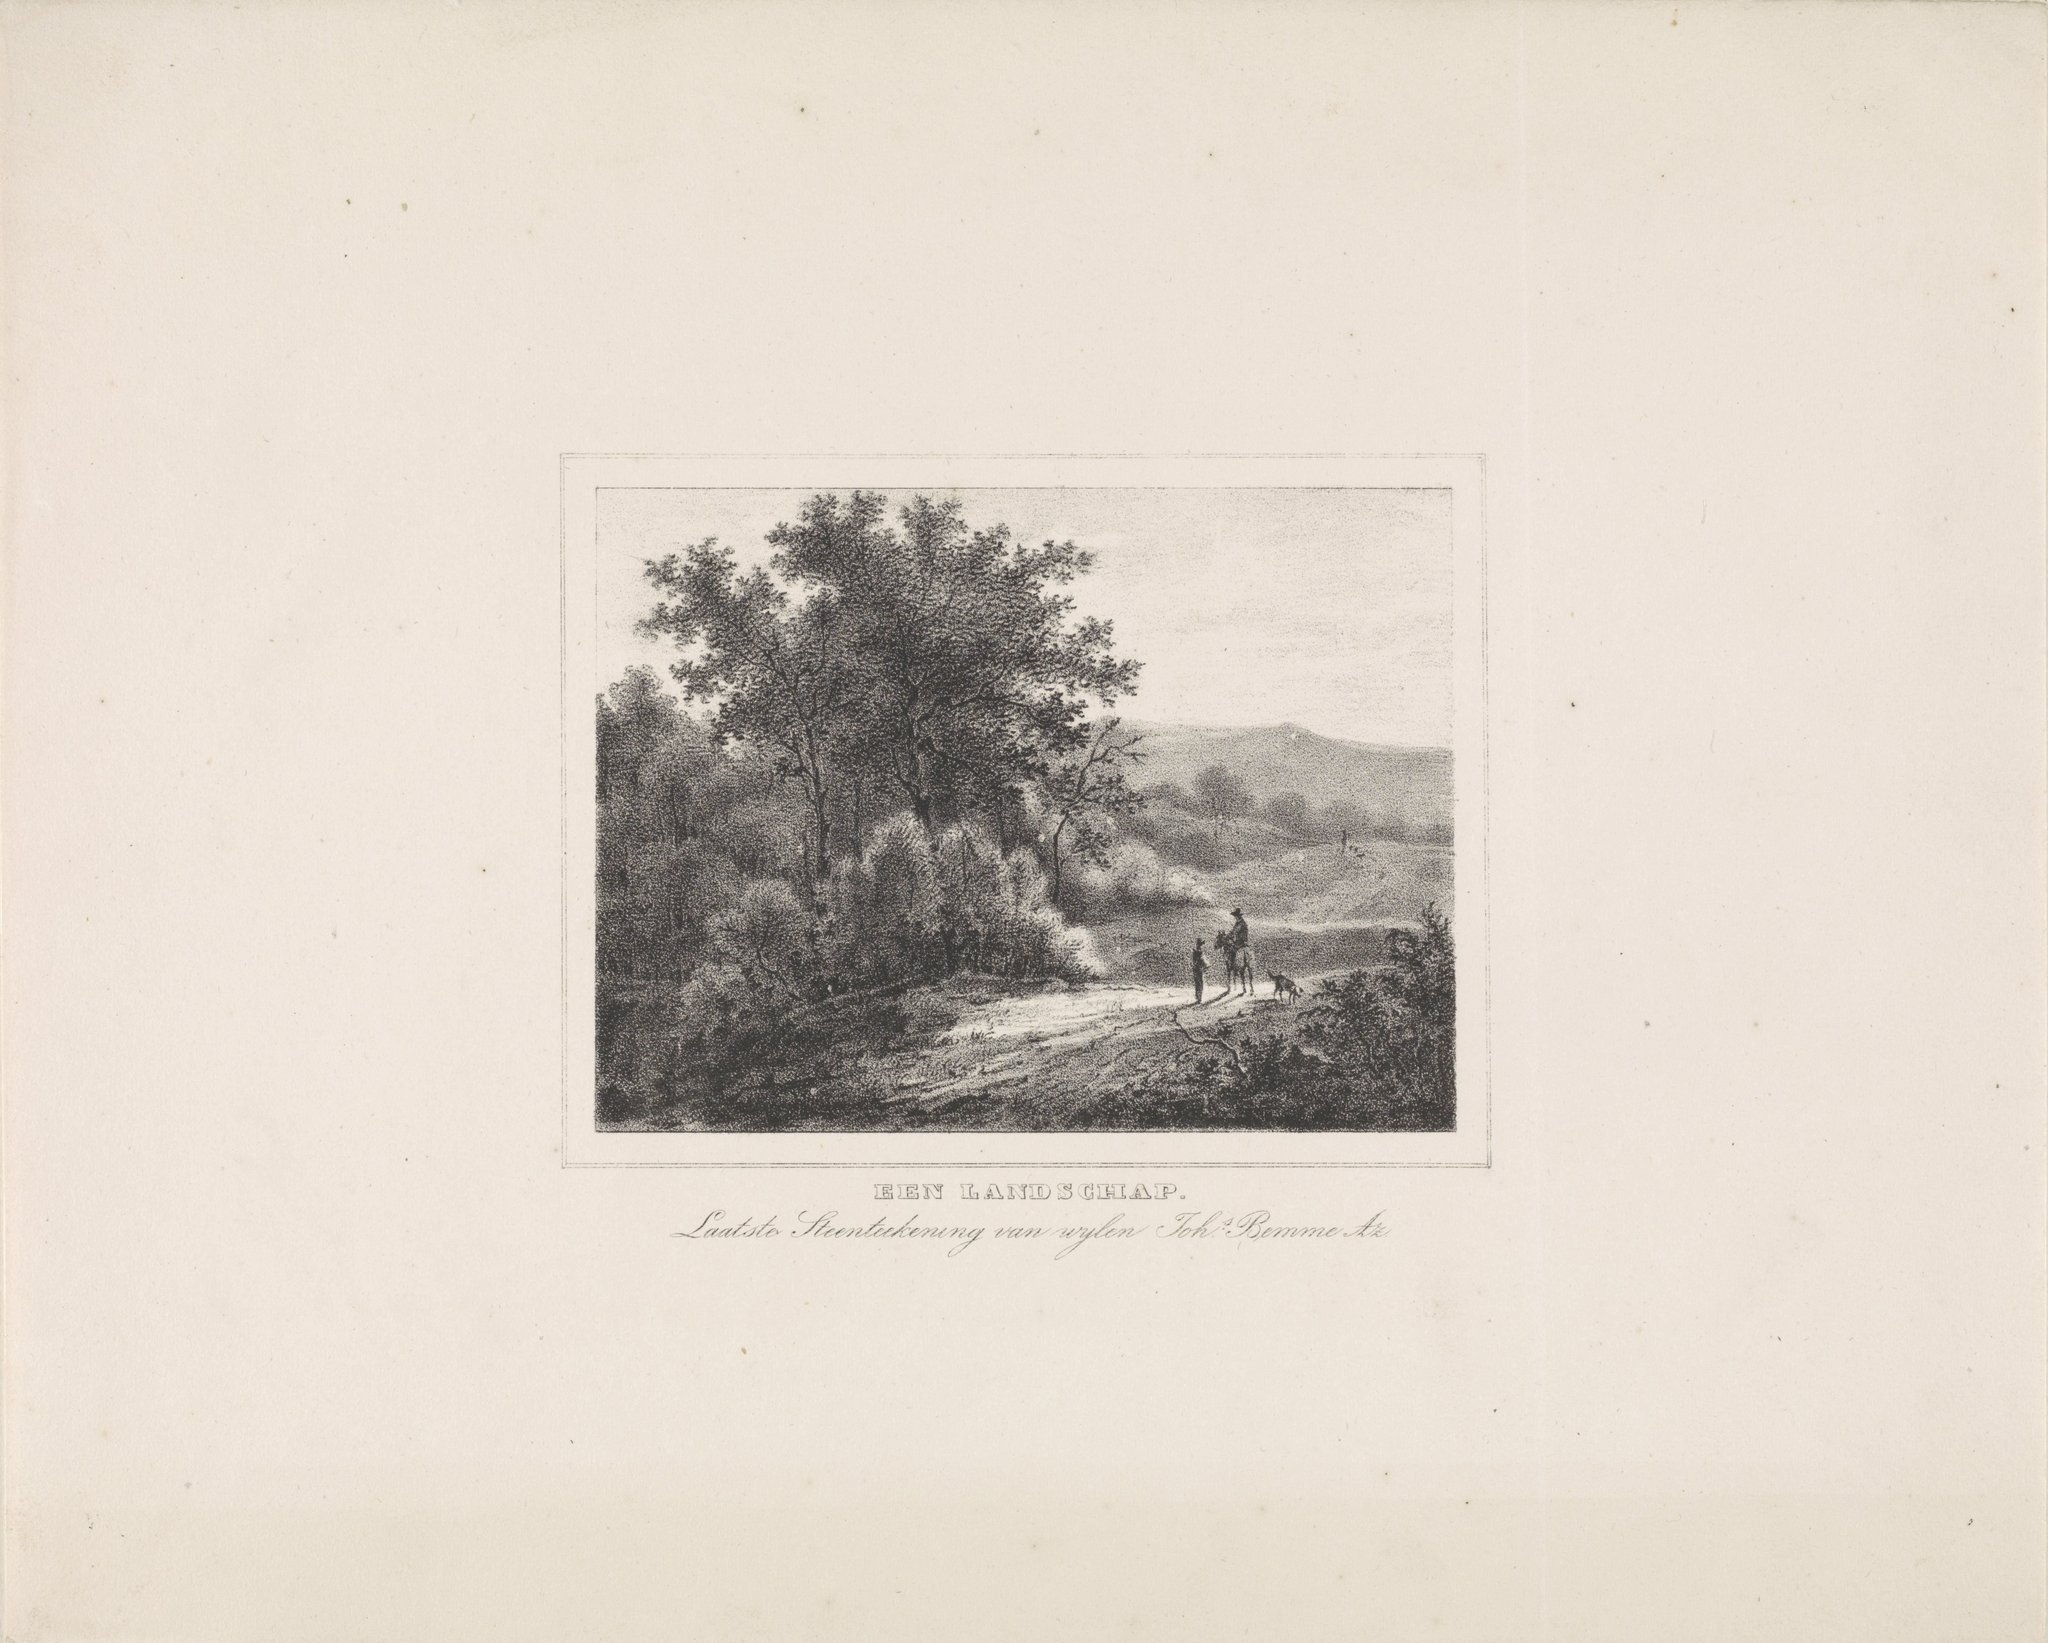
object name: print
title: Heuvelachtig landschap met figuren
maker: joannes bemme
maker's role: print maker, printer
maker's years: 1775-1841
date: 1841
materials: paper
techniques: lithograph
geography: netherlands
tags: low hill country, public road (+ city(-scape) with figures, staffage)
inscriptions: collector's mark: Lugt 2228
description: Op een landweg in een heuvelachtig landschap staan twee figuren, de een te voet de ander te paard. Naast hen een hond. Eronder staat gedrukt: Een landschap. Laatste steenteekening van wijlen Joh s: Bemme Az.